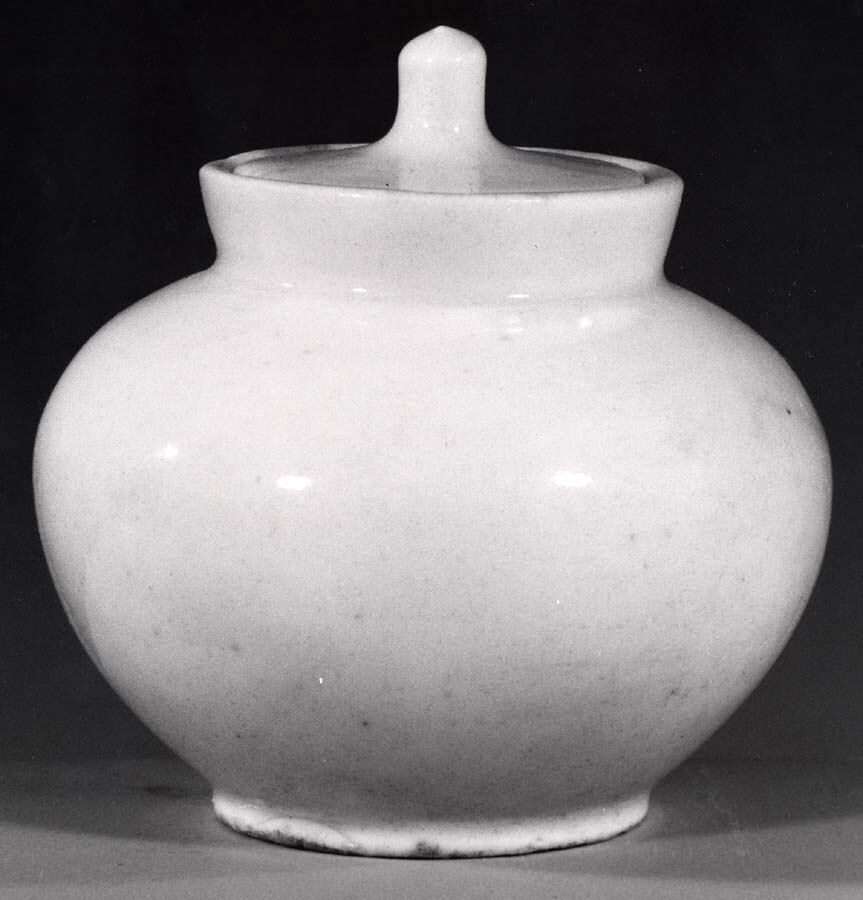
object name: jar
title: Small Jar with Cover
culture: korean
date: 1801-1900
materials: porcelain